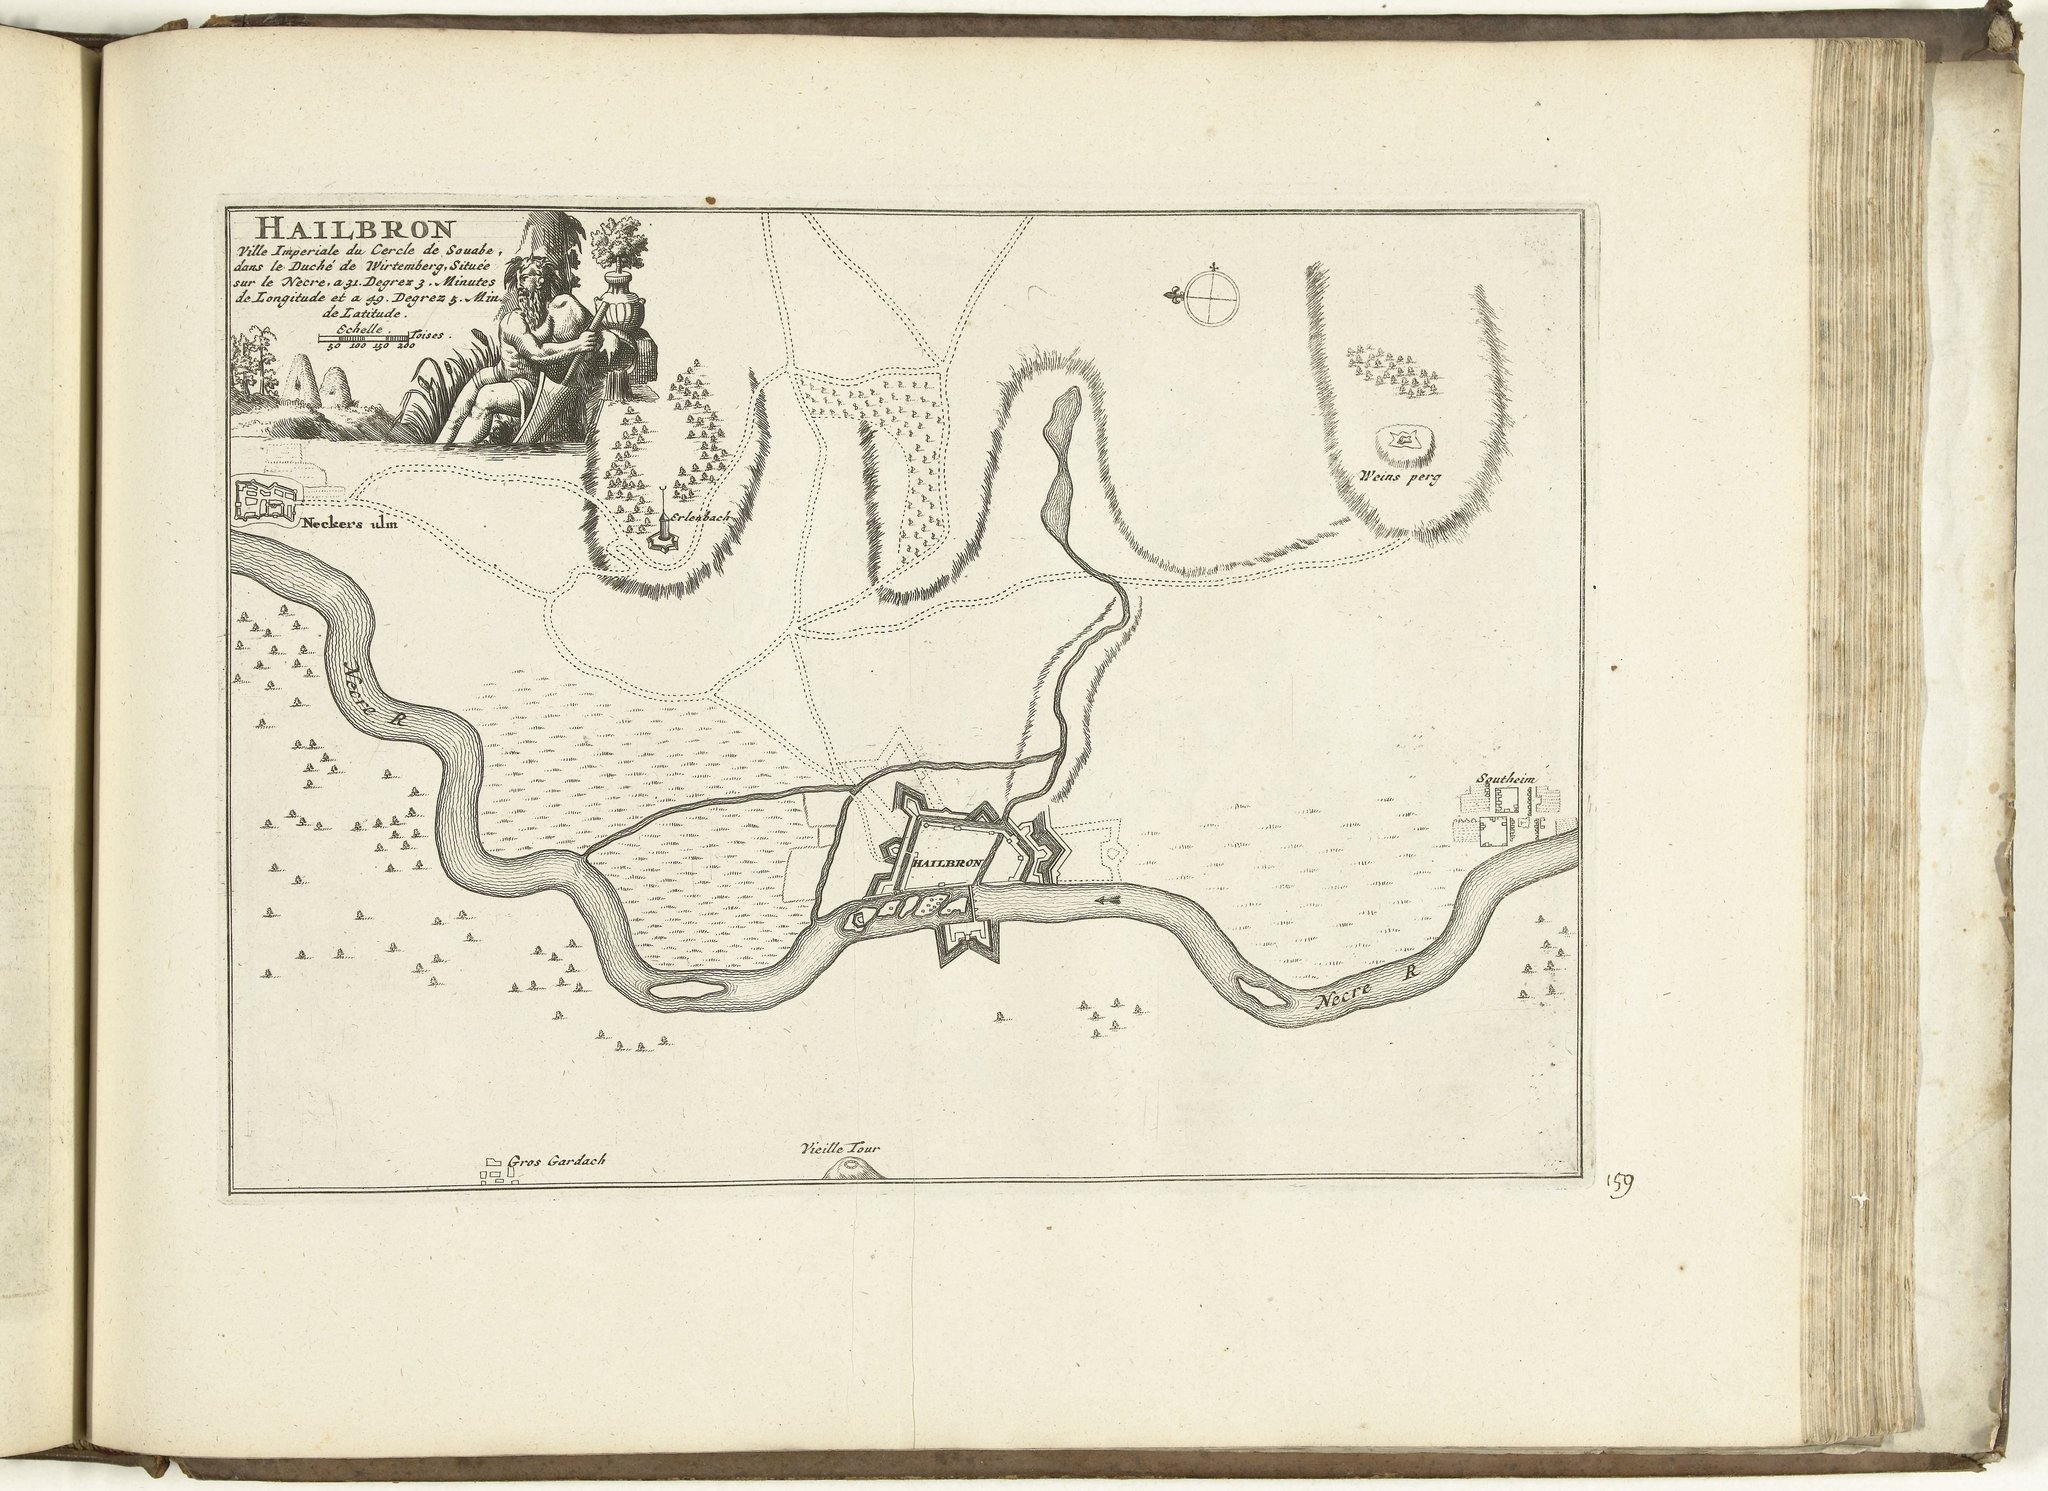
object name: map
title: Plattegrond van Heilbronn, 1726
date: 1726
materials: paper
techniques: etching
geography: leiden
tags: fortress, maps of cities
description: Plattegrond van de versterkingen om de stad Heilbronn. Plaat nr. 159 in deel VII van het prentwerk: Les Forces de l'Europe, Asie, Afrique et Amerique ... Comme aussi les Cartes des Côtes de France et d'Espagne uit 1726, dit eerste deel met 238 met de hand genummerde platen van vermaarde sterke steden en vestingen in het kader van de Spaanse Successieoorlog 1701-1713. Voor het merendeel zijn deze platen gekopieerd naar de anonieme Franse platen van vermaarde sterke steden en vestingen: in Les forces de l'Europe en in: Le theatre de la guerre, dans les Pays-Bas, beide oorspronkelijk uitgegeven door Nicolas de Fer te Parijs (1693-1697) in het kader van de Negenjarige Oorlog. Titel en opschriften in het Frans. Rechtsonder sporen van het weggepolijste nummer: 117.